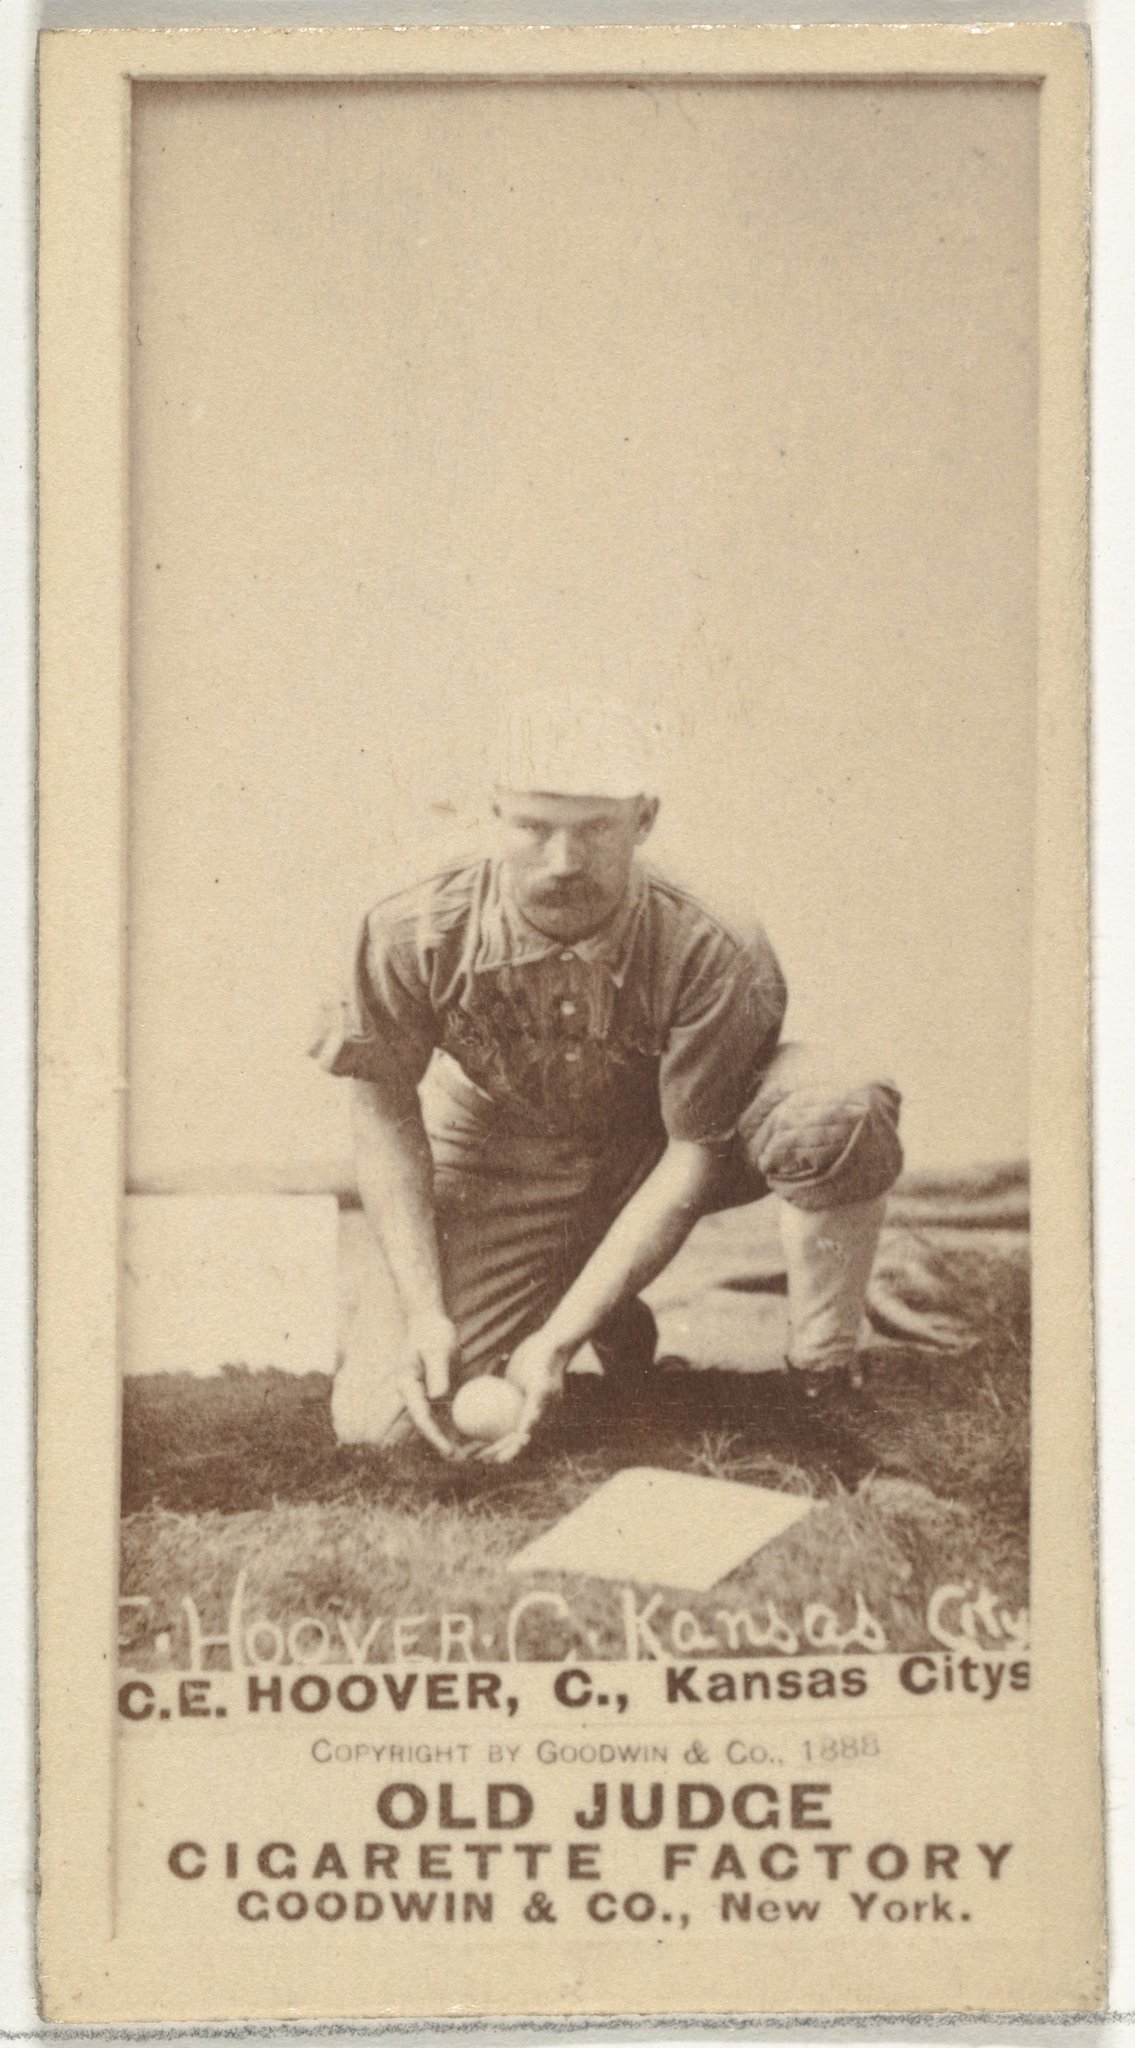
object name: baseball card, photograph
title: Charles E. "Charlie" Hoover, Catcher, Kansas City Cowboys, from the Old Judge series (N172) for Old Judge Cigarettes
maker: goodwin & company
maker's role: publisher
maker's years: 1850-1950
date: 1888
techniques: albumen silver print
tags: men,portraits,baseball,athletes